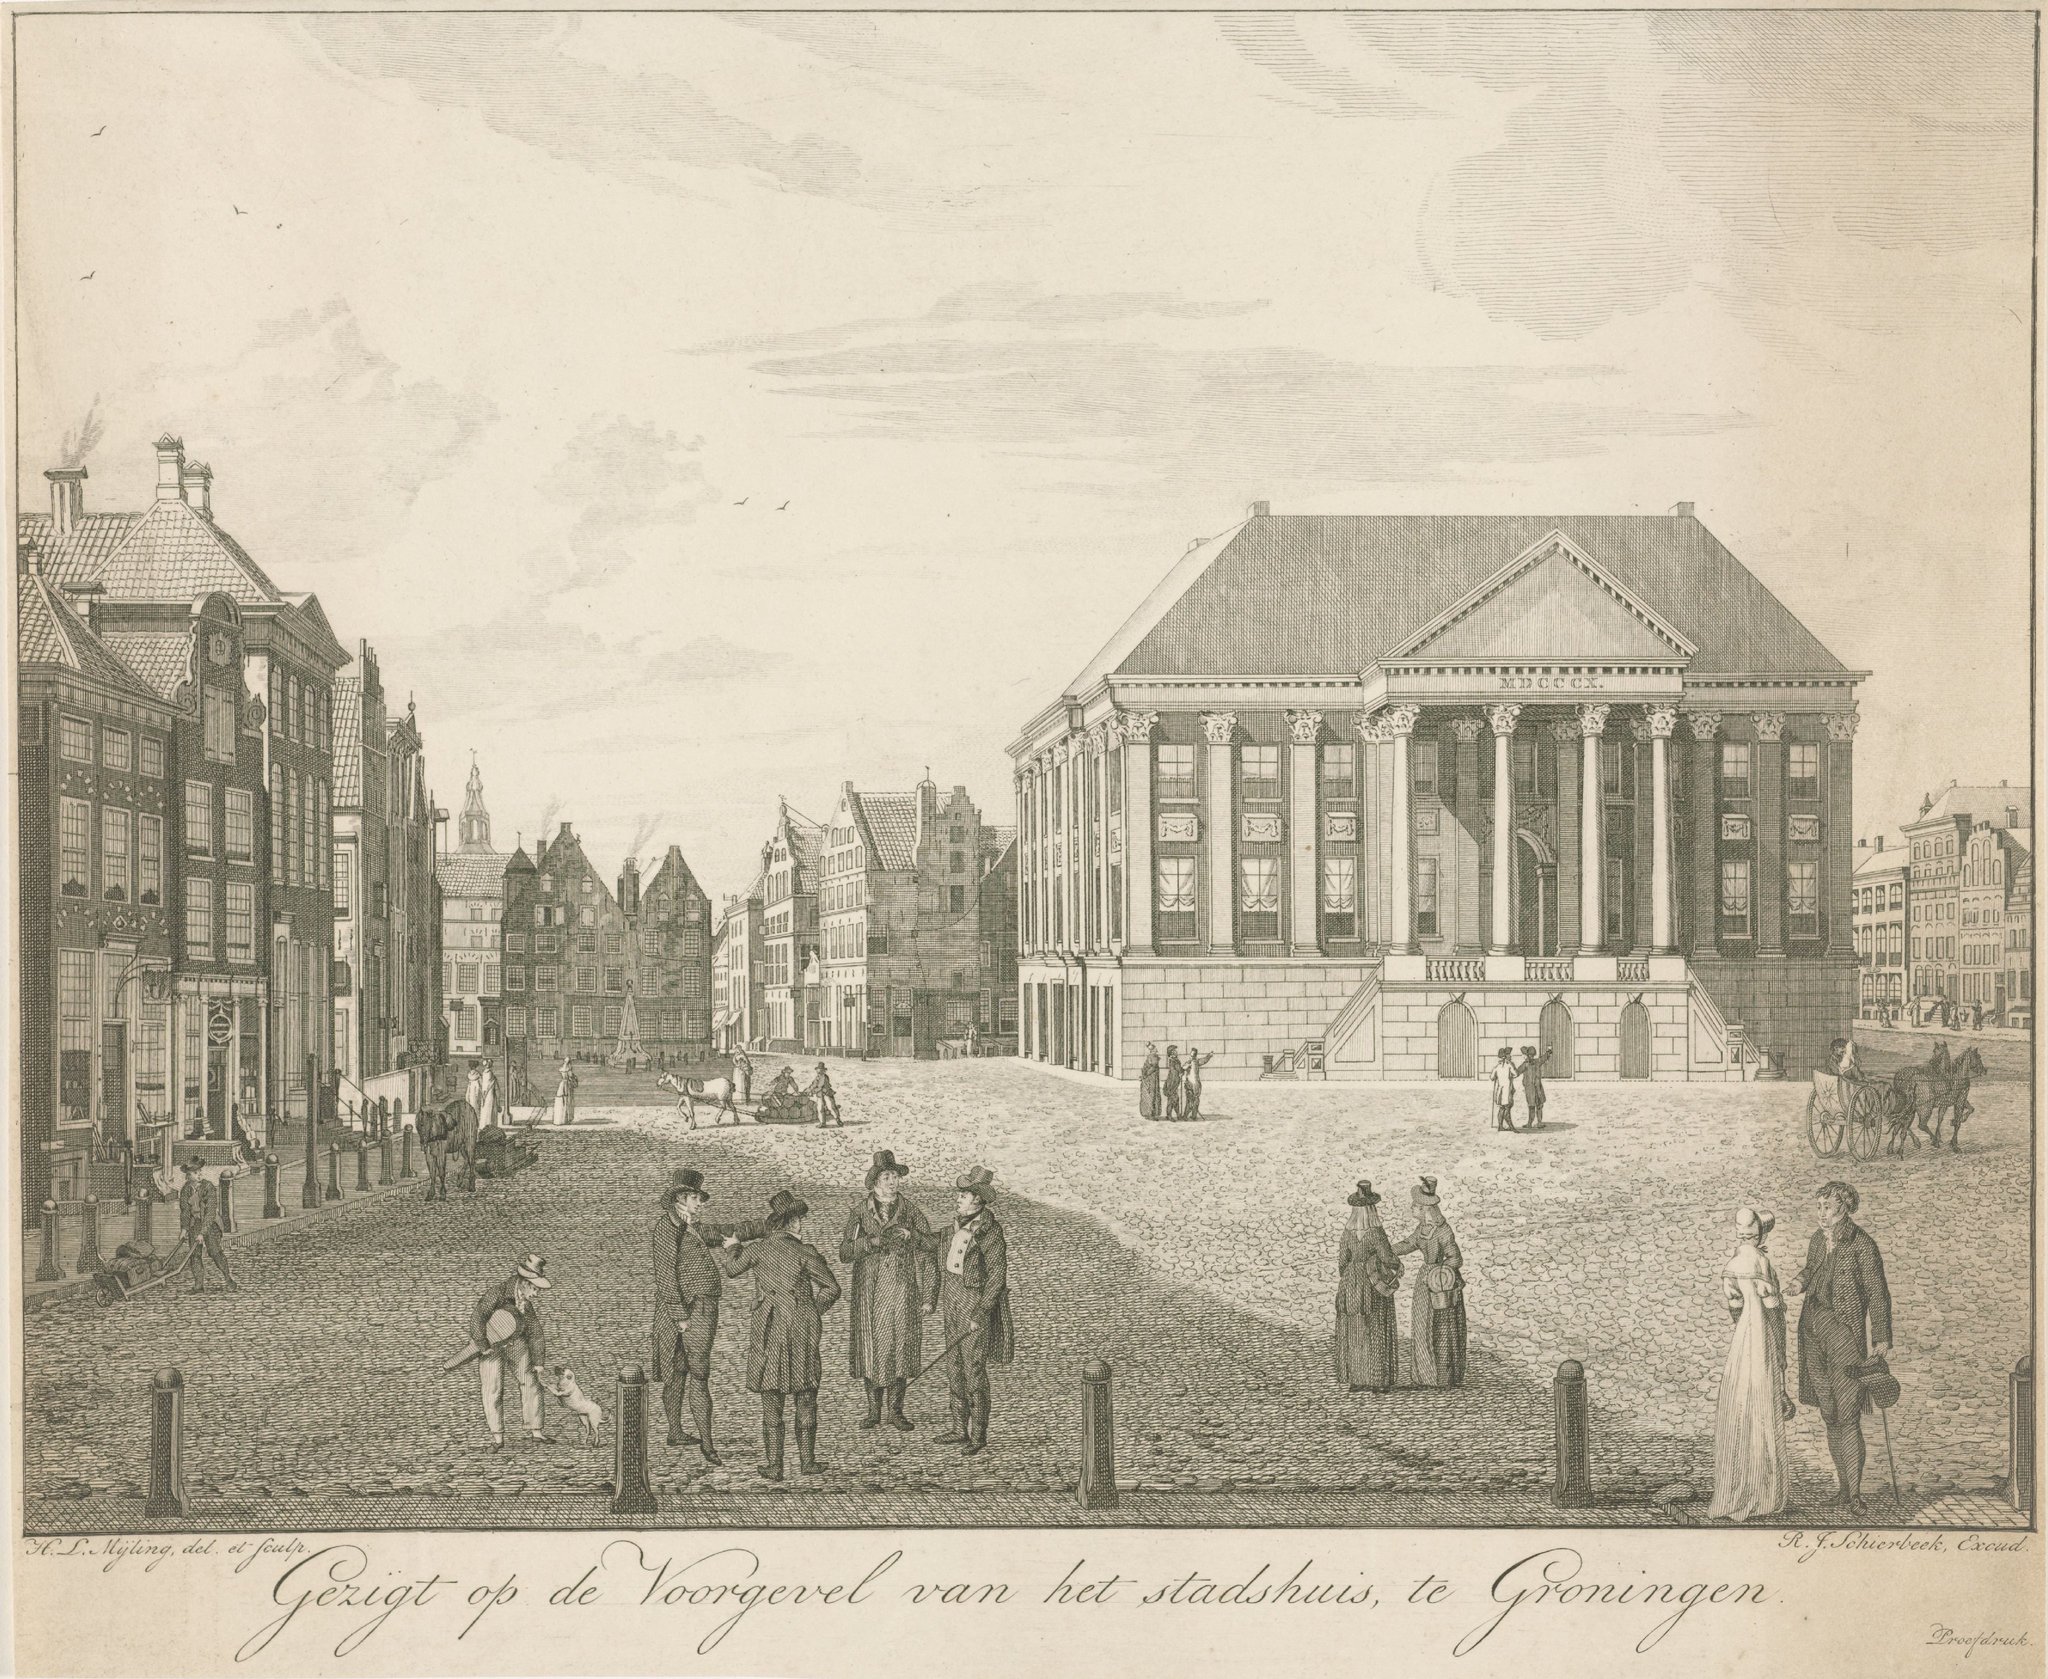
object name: print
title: Gezigt op de Voorgevel van het stadshuis, te Groningen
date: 1810-1821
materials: paper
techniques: etching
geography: groningen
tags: townhall, village square, place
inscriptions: collector's mark: Lugt 2228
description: Het stadhuis van Groningen, aan de Grote Markt. Op het plein mensen en een koets.